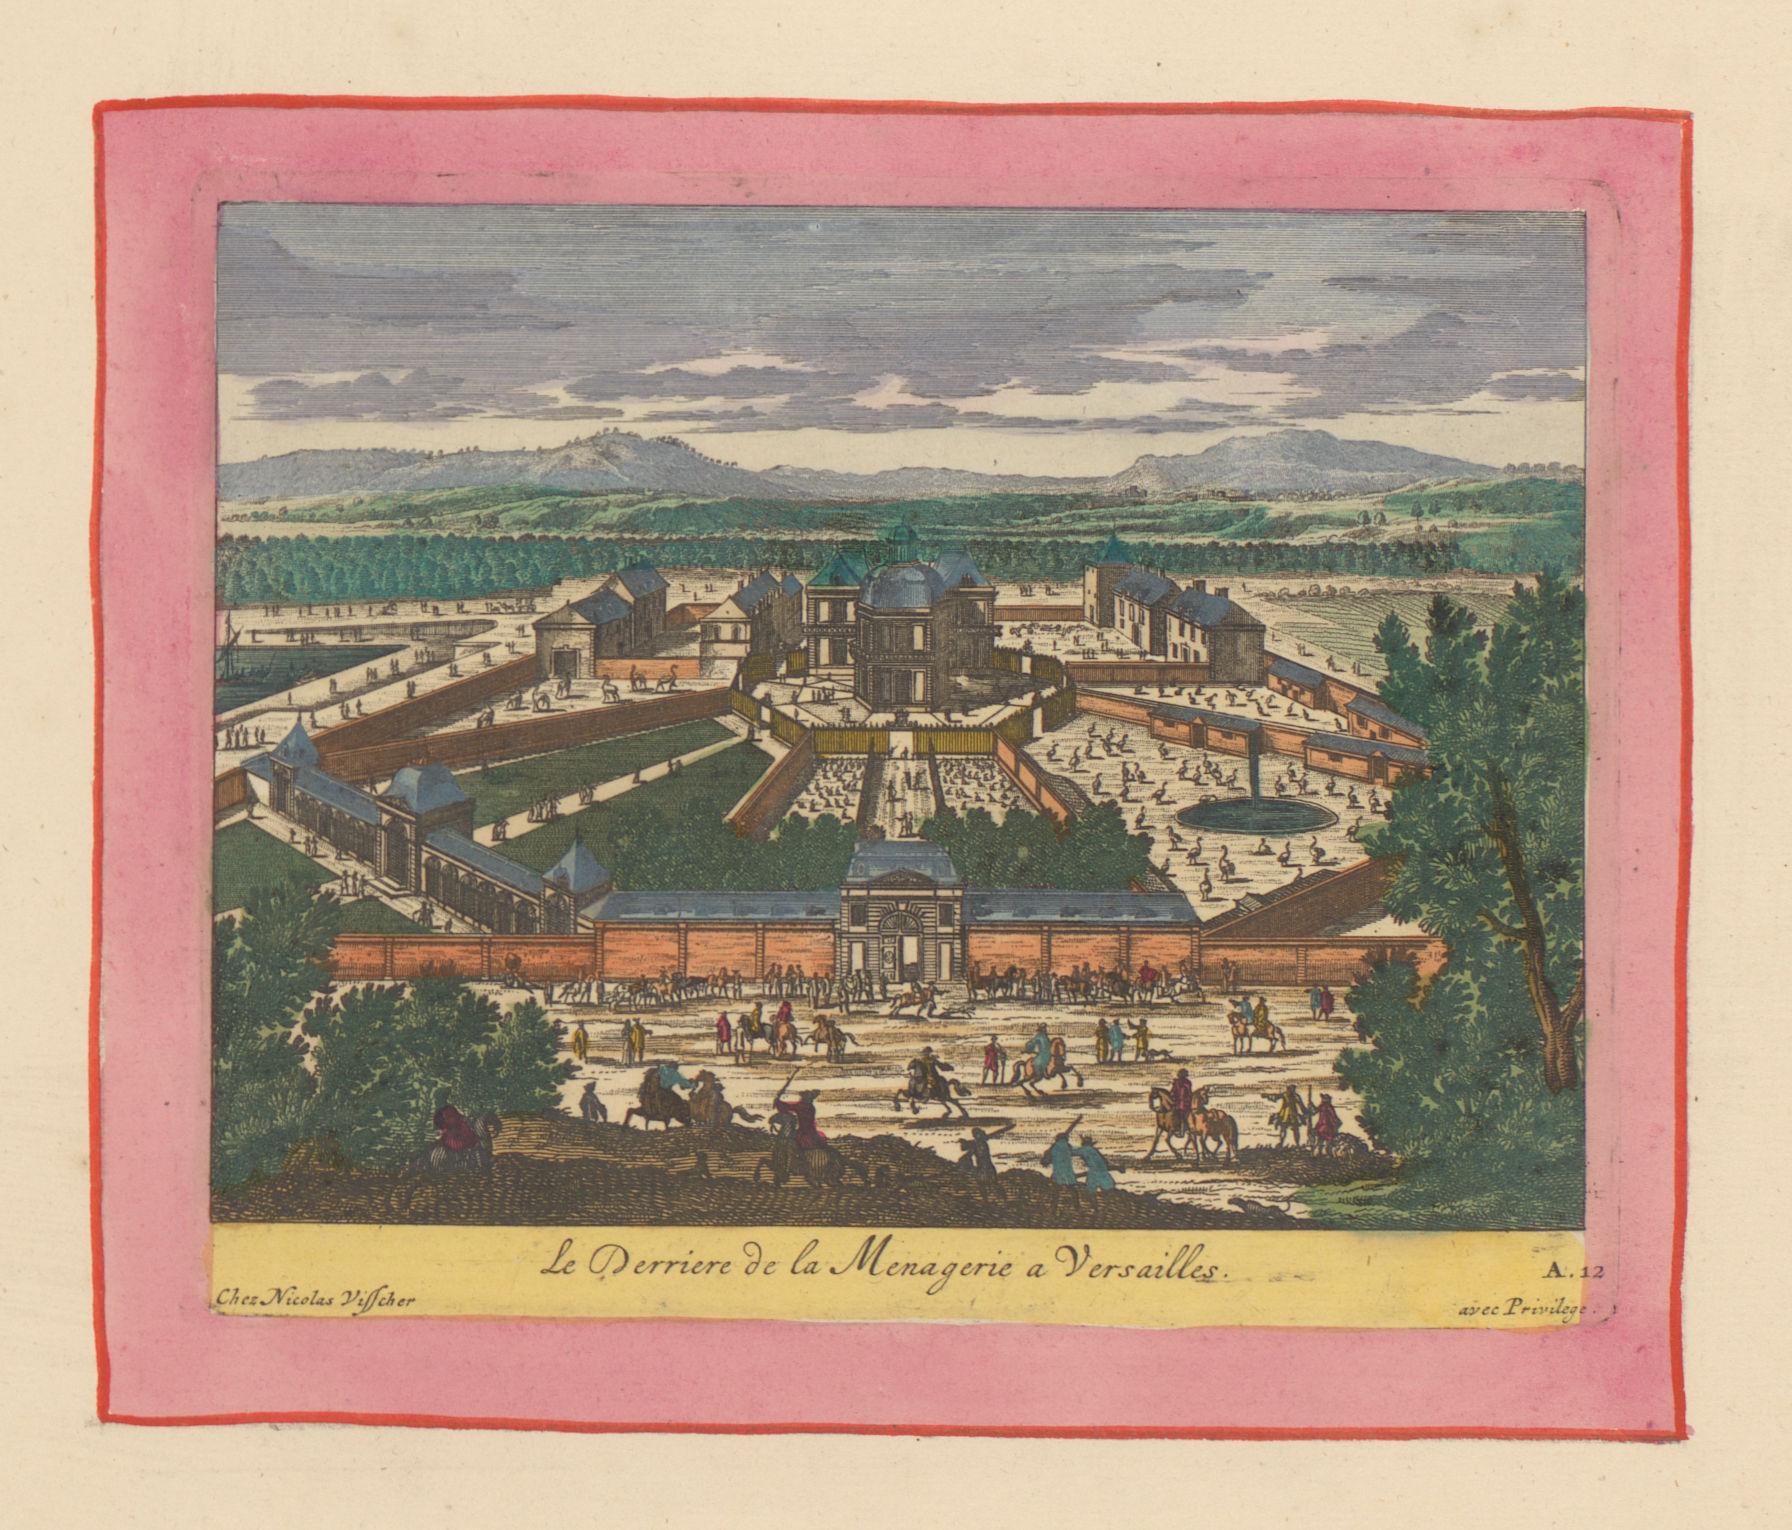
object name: print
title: Le Derriere de la Menagerie a Versailles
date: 1686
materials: paper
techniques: etching, hand coloring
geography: amsterdam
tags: french or architectonic garden; formal garden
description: De prent maakt deel uit van een serie bestaande uit 87 genummerde prenten (volgens Hollstein). De serie is opgedeeld in de delen A t/m F.